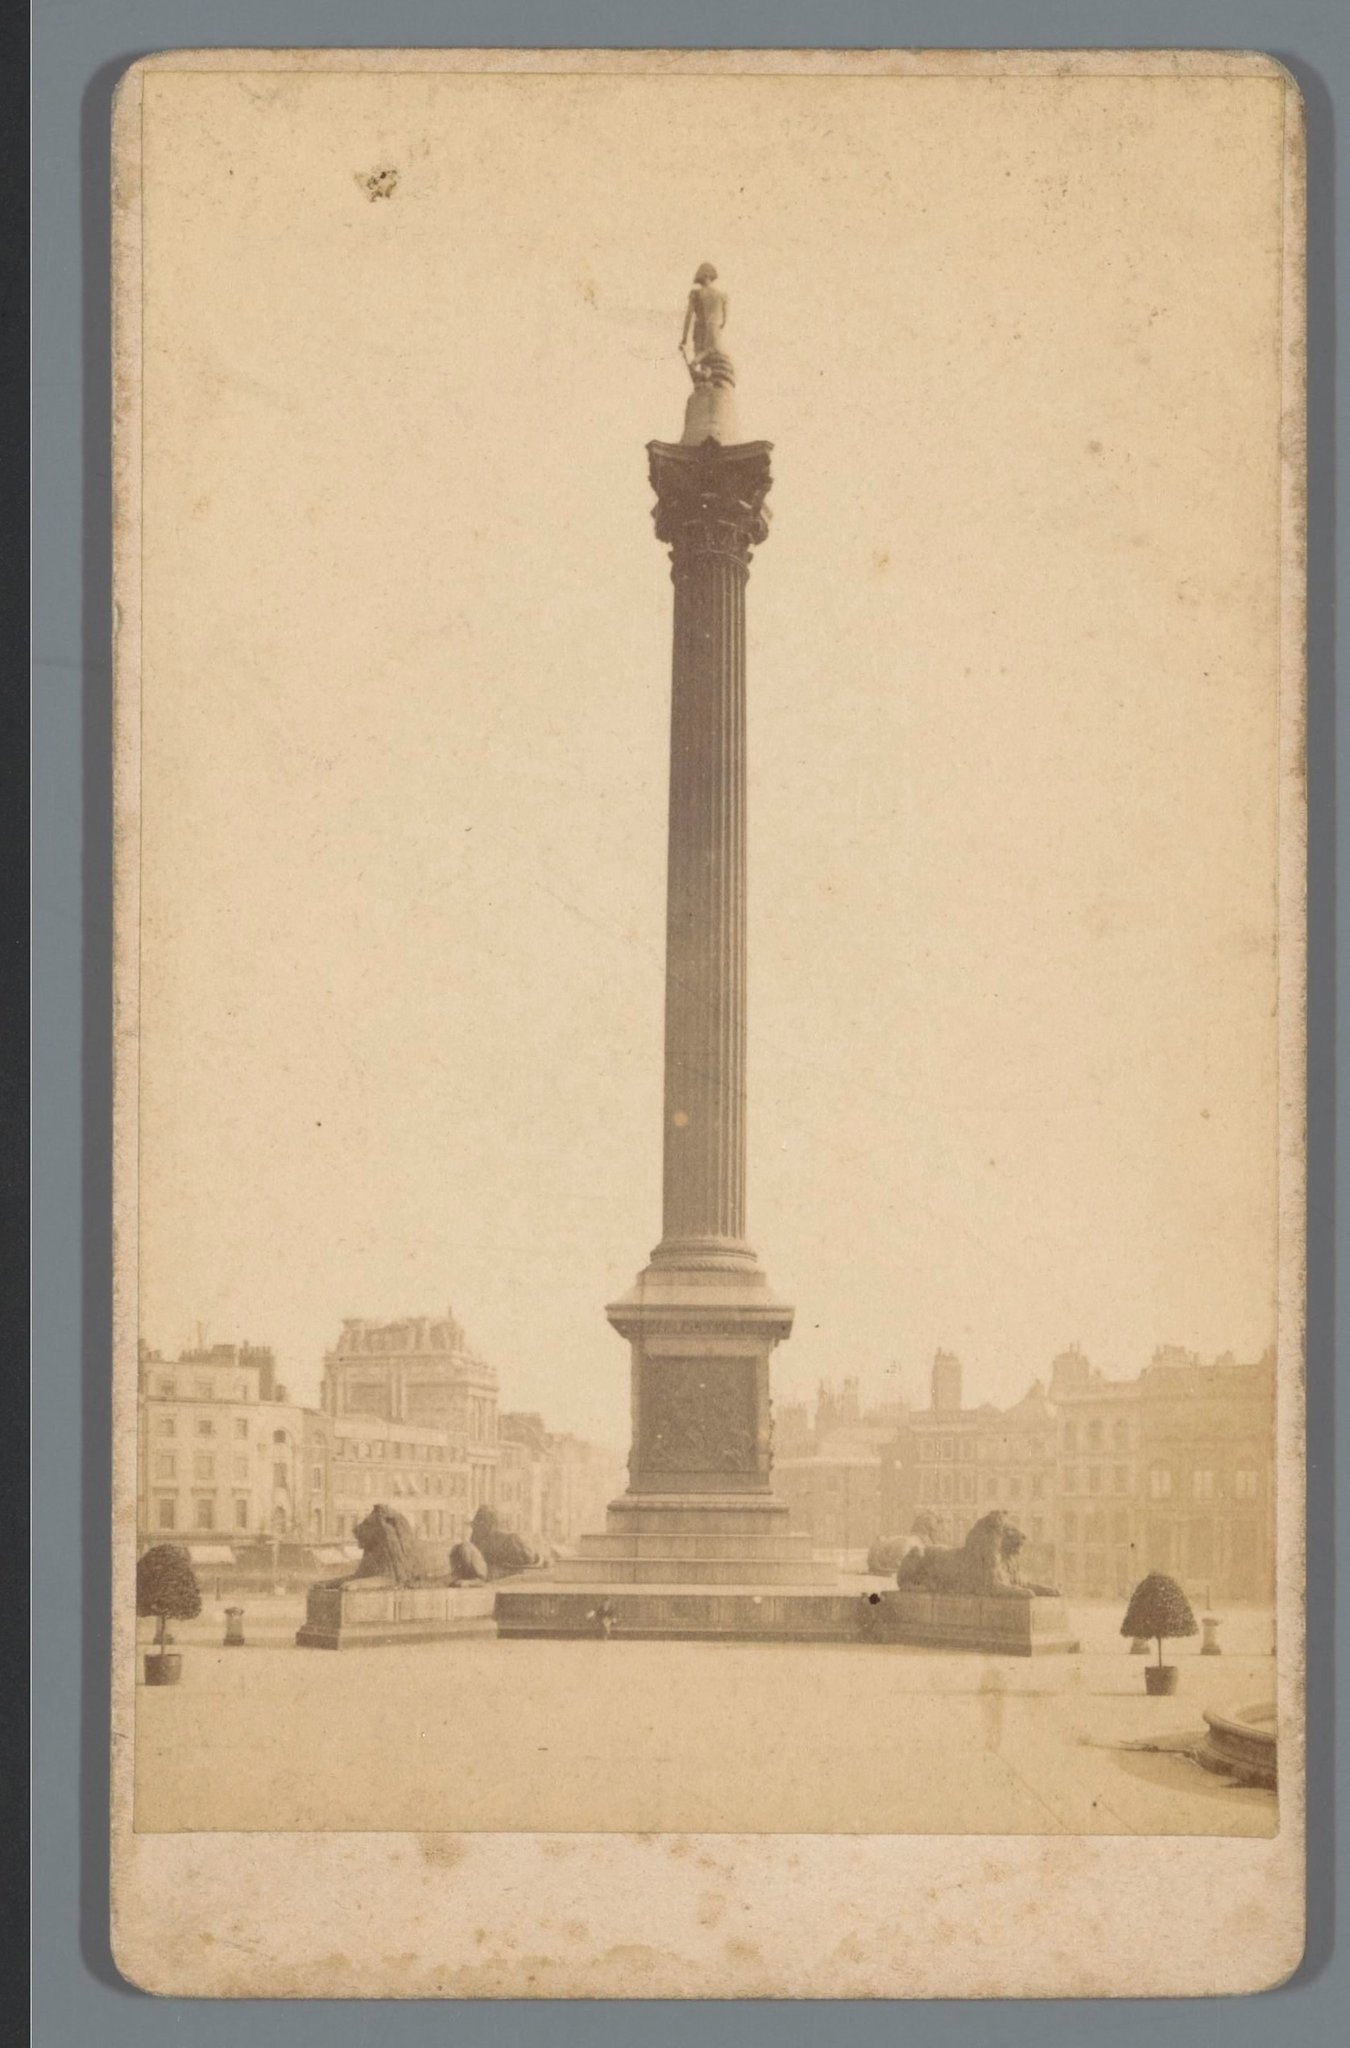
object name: carte de visite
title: Trafalgar Square from National Gallery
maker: Anonymous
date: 1865-1870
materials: cardboard, paper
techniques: albumen print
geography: london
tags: square, place, circus, etc., triumphal column with helical friezes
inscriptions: number: ‘27.’, address: ‘Published by/ Dalton and Lucy/ Booksellers to the Queen/ 28, Cockspur Street, S.W.’